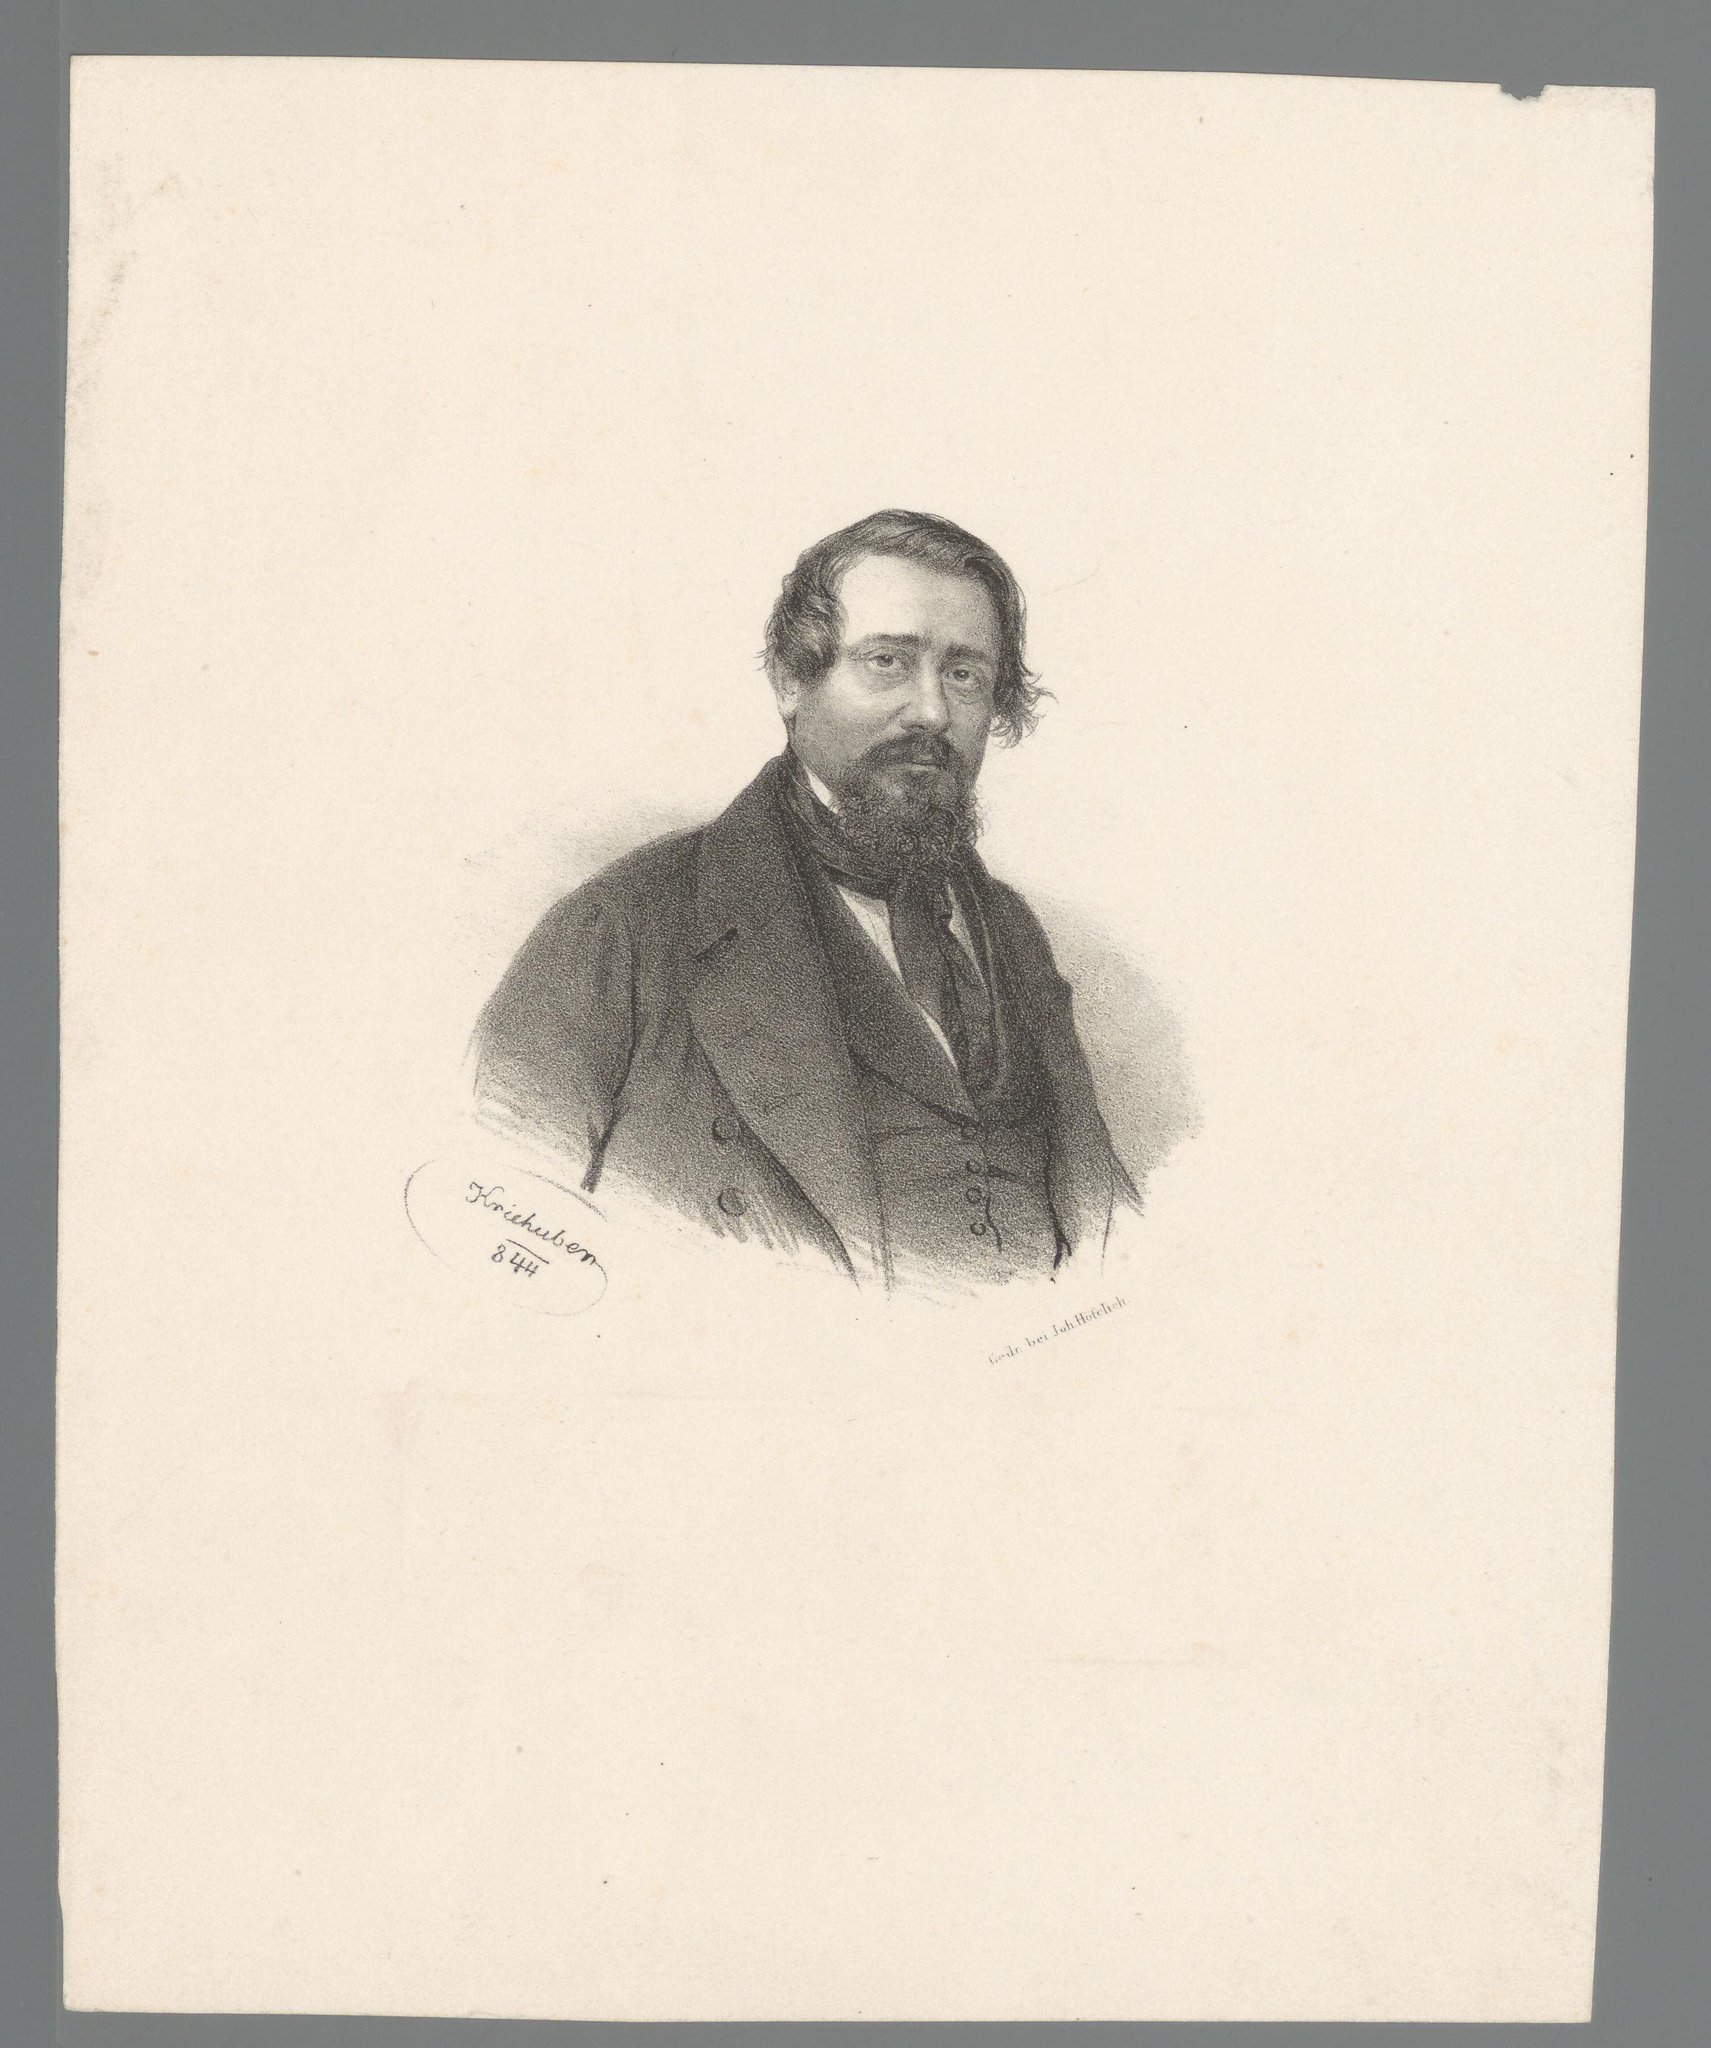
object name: print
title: Portret van Ferencz Szapary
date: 1844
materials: paper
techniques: lithograph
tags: science and technology, historical persons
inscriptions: collector's mark: Lugt 2228